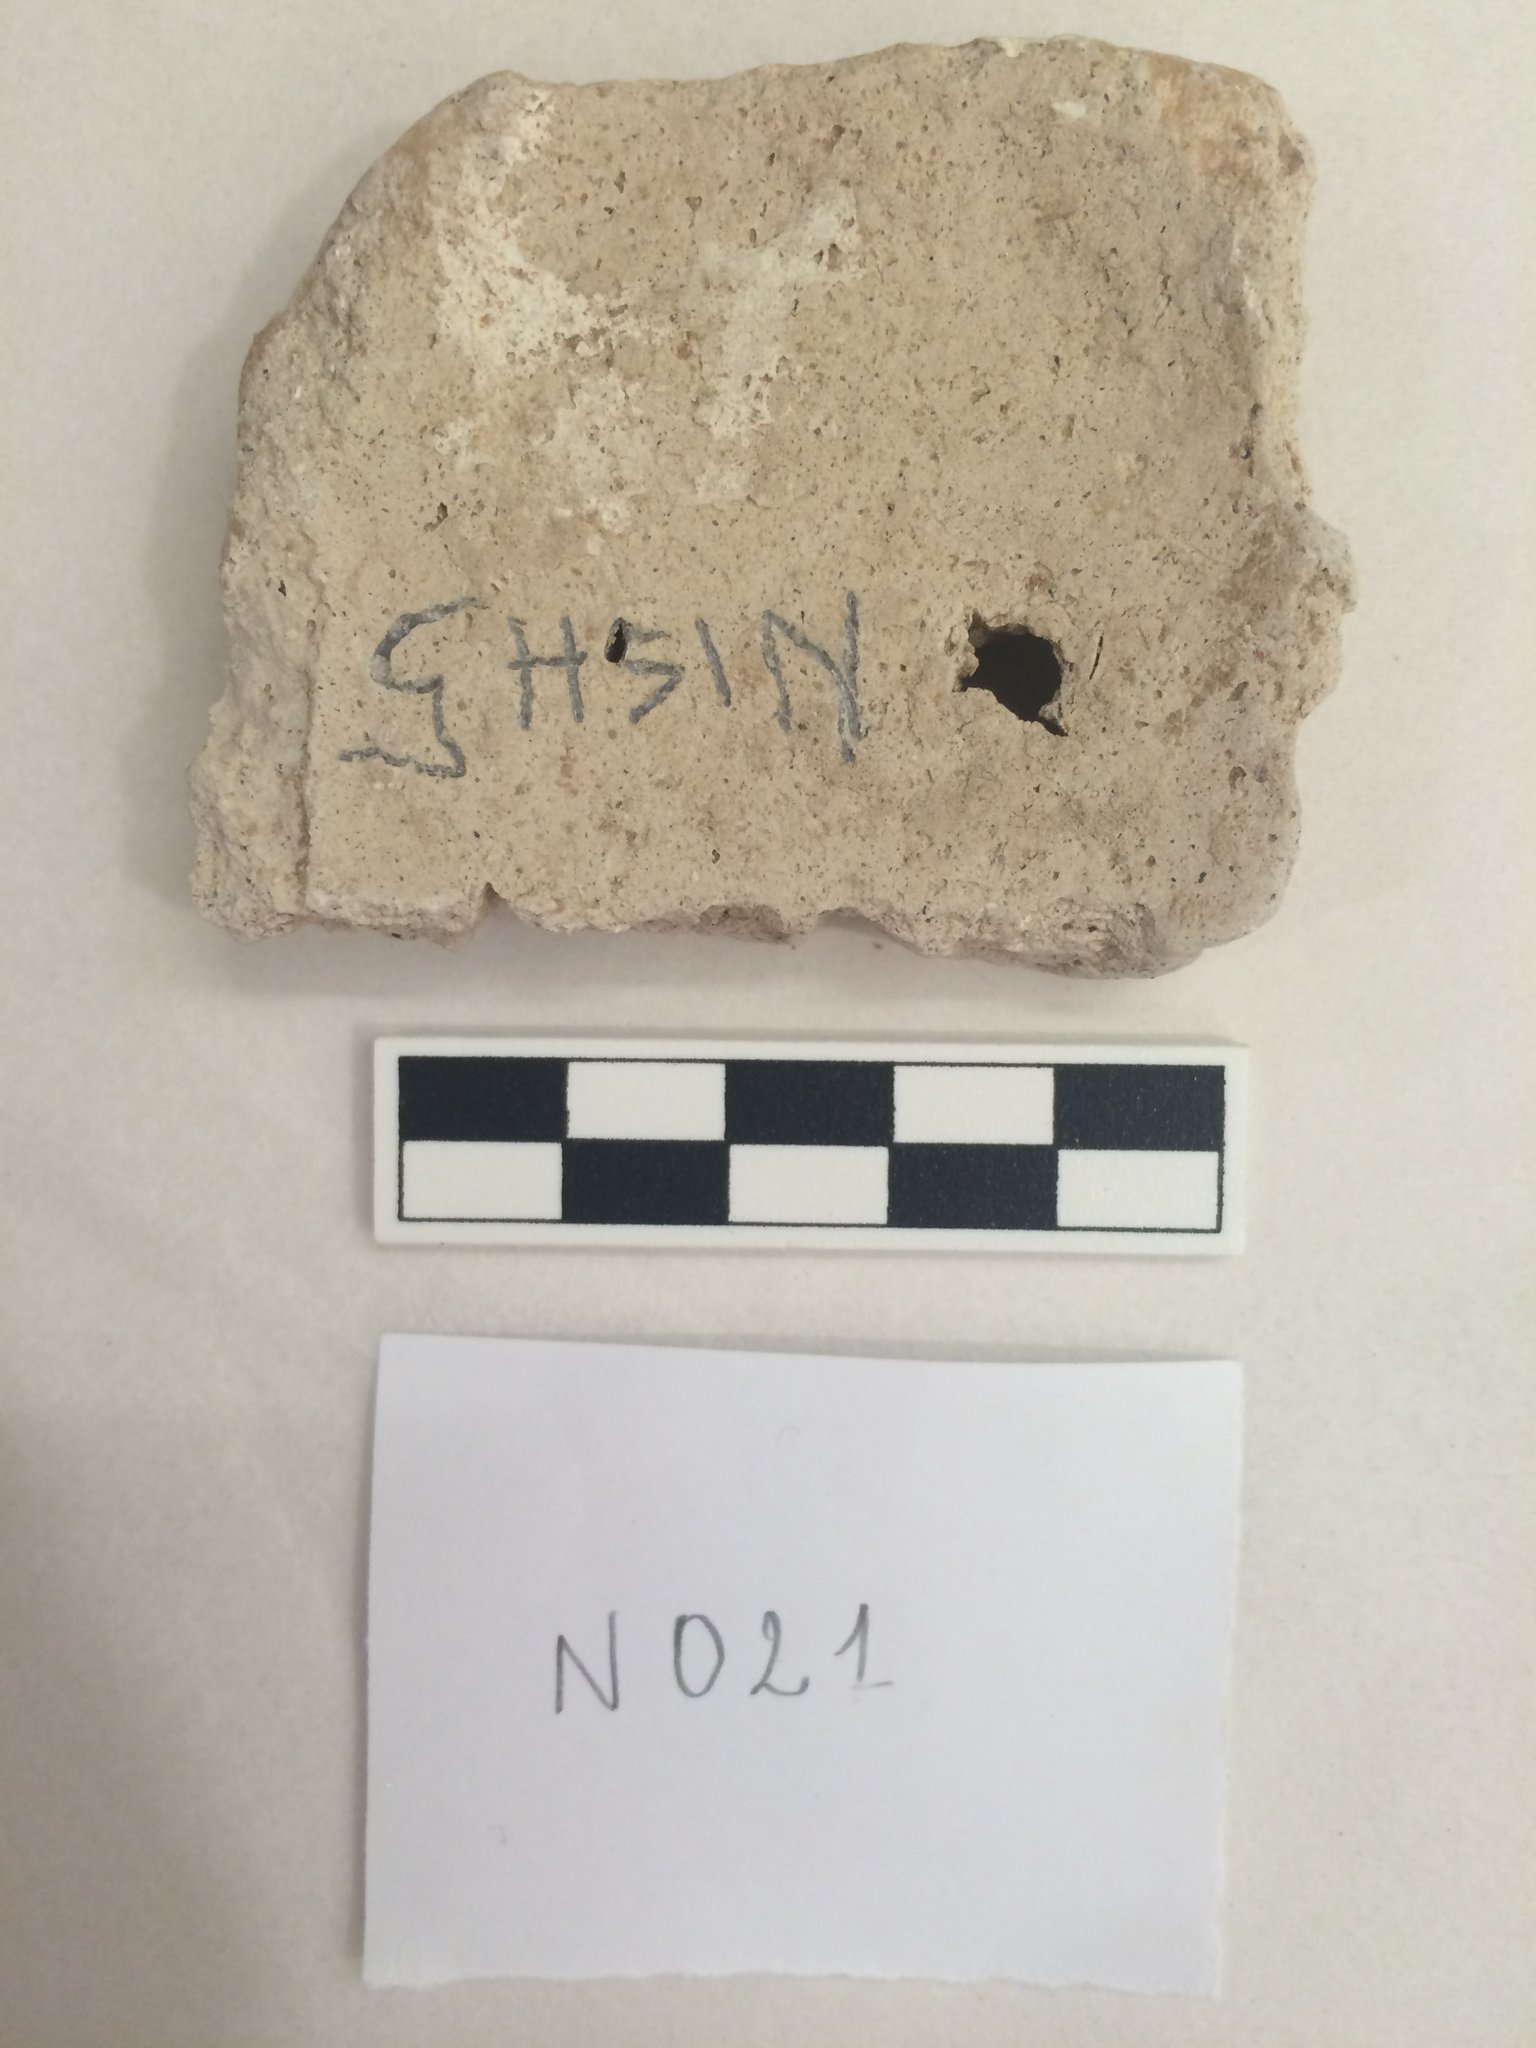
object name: fragment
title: Stucco Fragment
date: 701-1200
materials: plaster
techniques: carving, painting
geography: iran